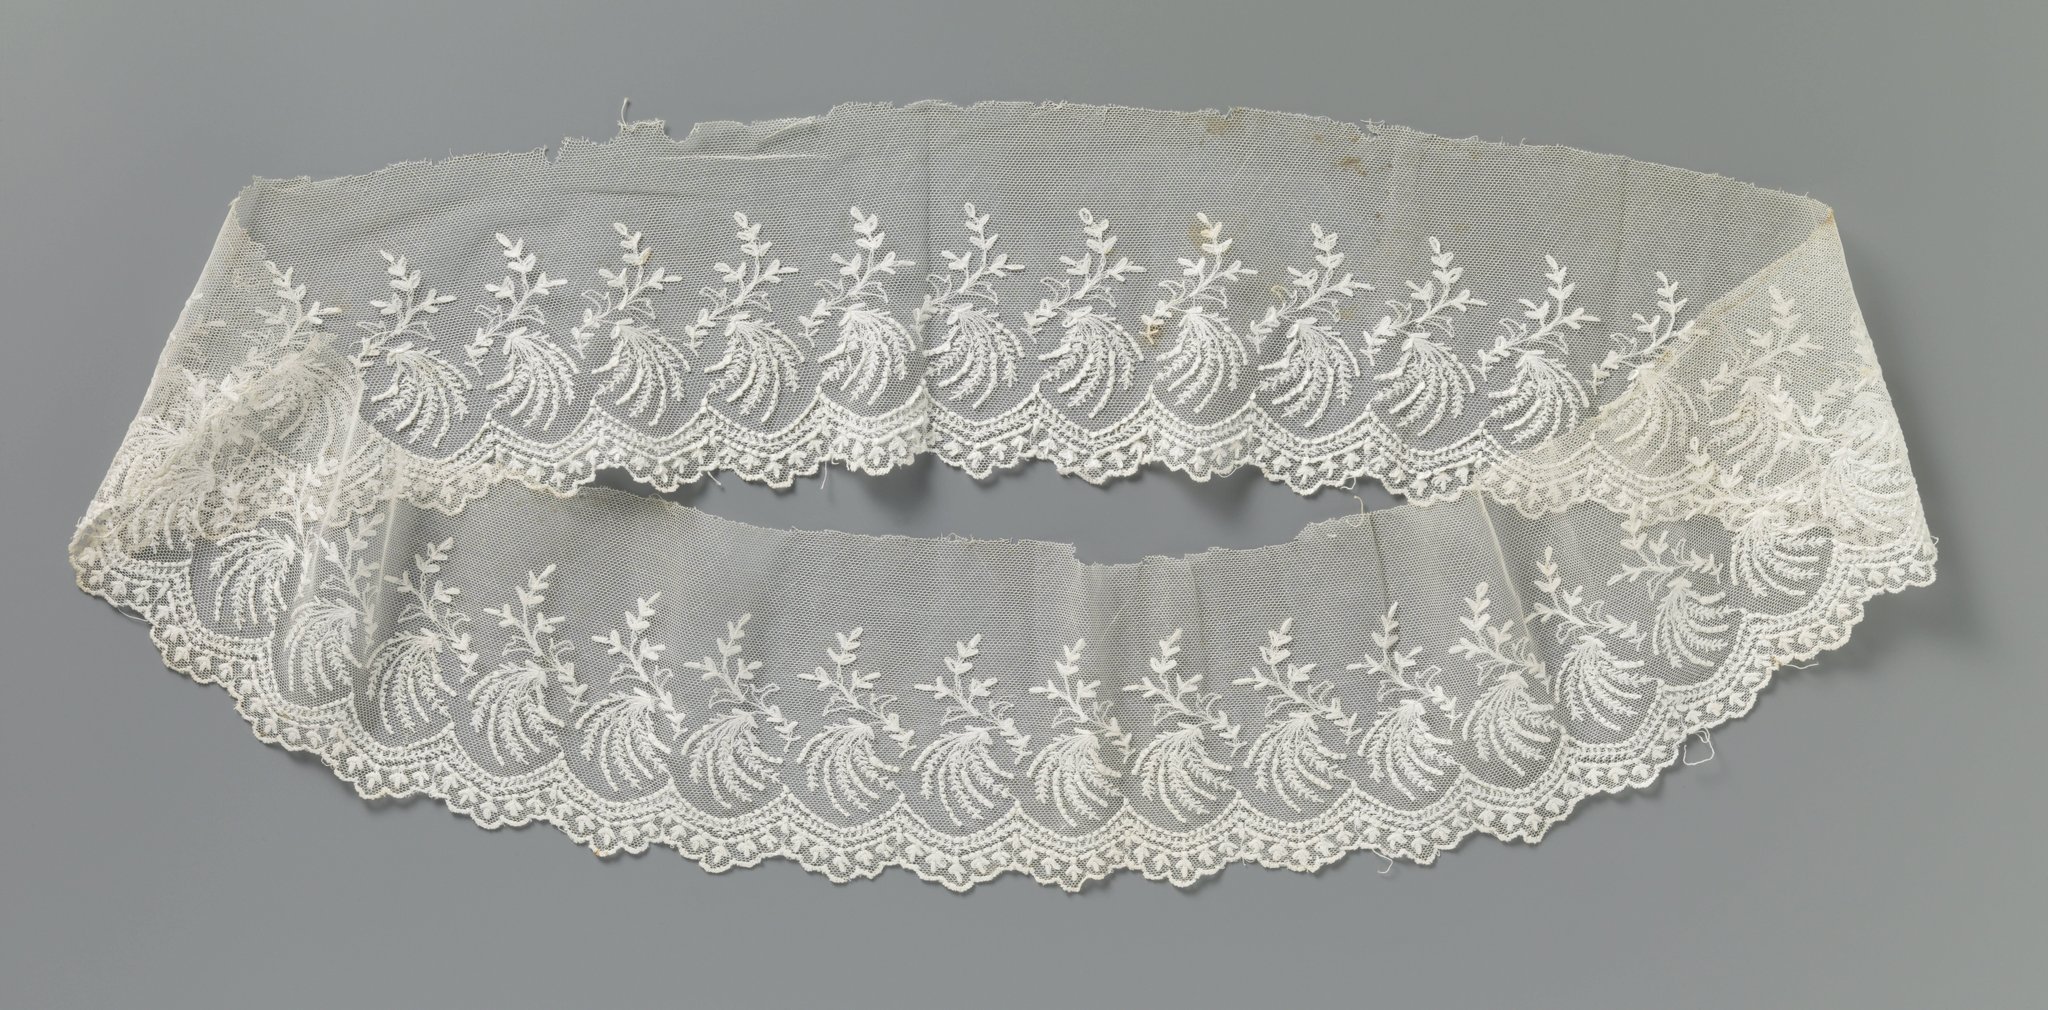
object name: strip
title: Strook kantborduurwerk op machinale tule met grashalmen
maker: Anonymous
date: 1900-1949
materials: cotton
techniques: embroidered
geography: plauen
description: Strook naturelkleurig kantborduurwerk op machinale tule, tuleborduurwerk. Repetitief motief van een hangend bosje met zeven grashalmen en één gebogen tak met bladeren, op een fijne zeshoekige maasgrond. De bosjes hangen boven een geschulpte rand van bandwerk met hangende blaadjes. De bovenzijde is afgeknipt en niet afgewerkt. De korte zijden van de strook zijn aan elkaar genaaid.